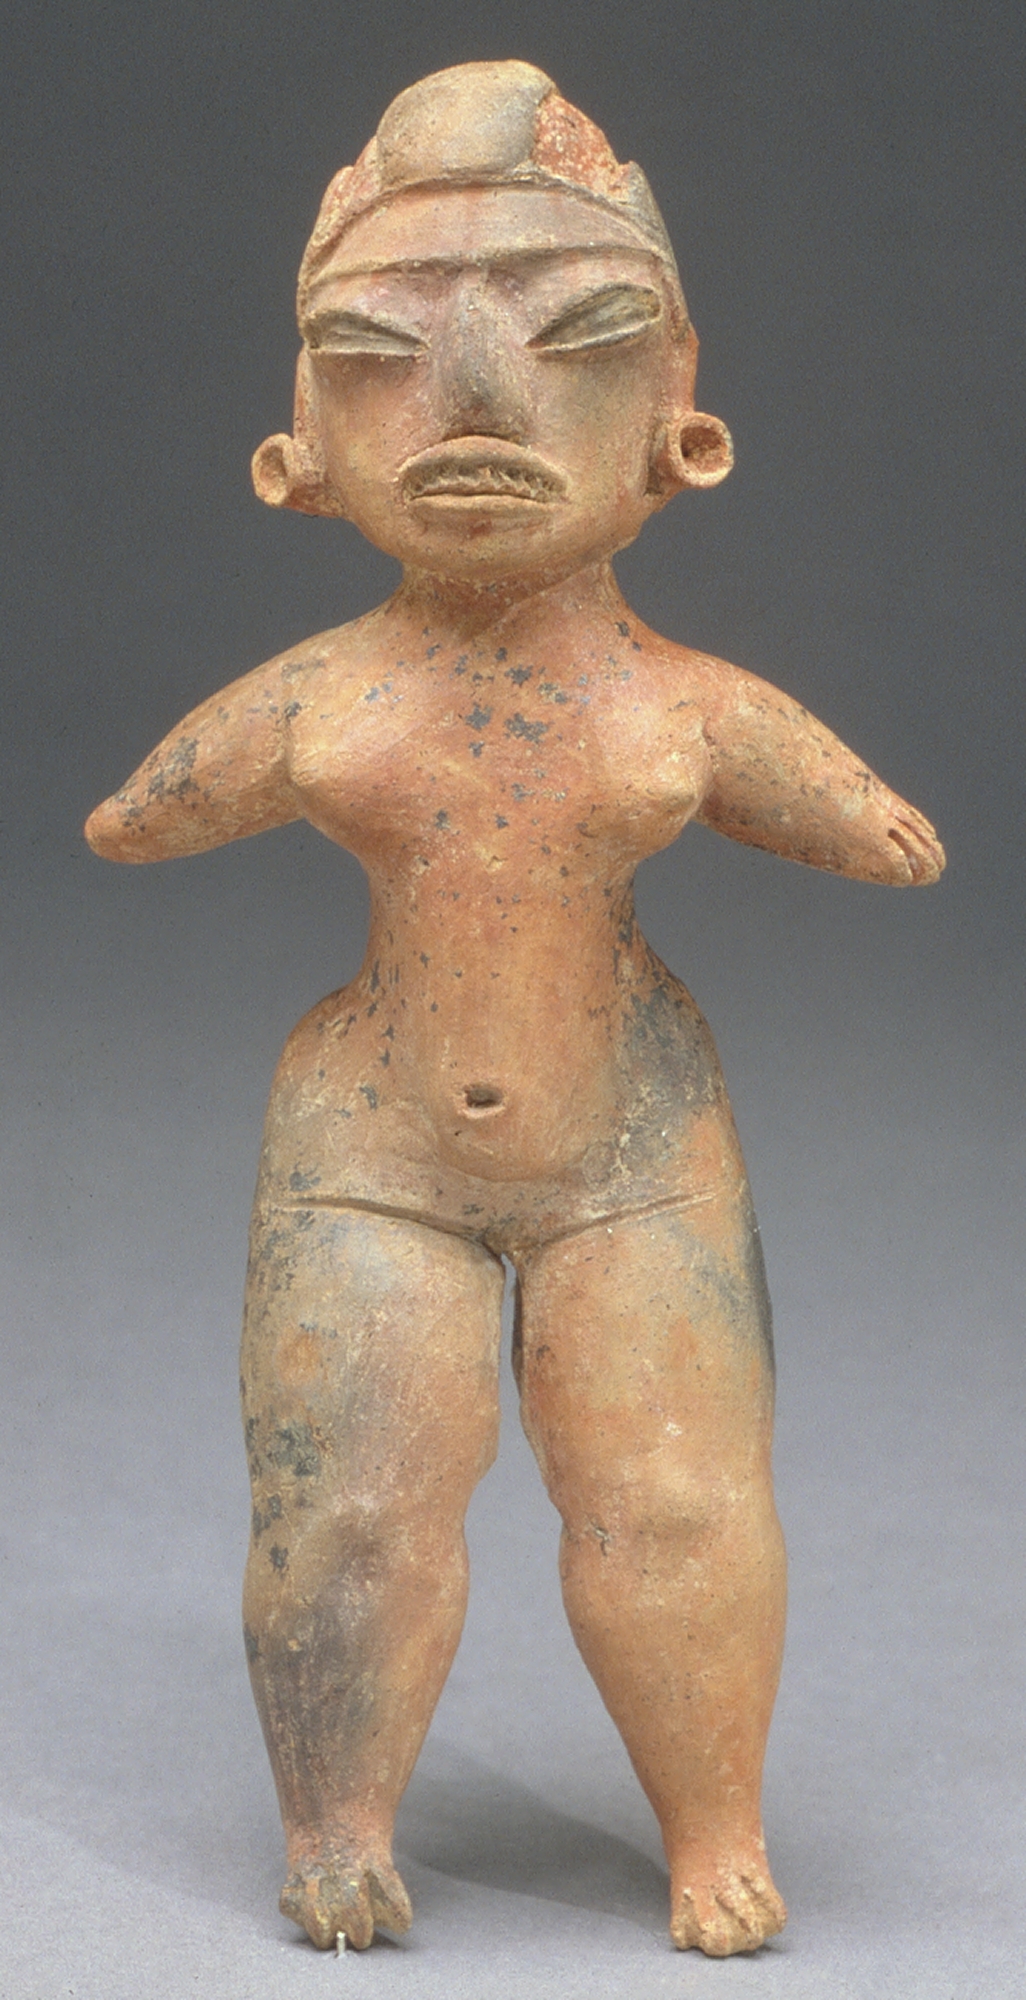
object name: female figure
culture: olmec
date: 1200-801 BCE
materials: ceramic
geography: mexico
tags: female nudes